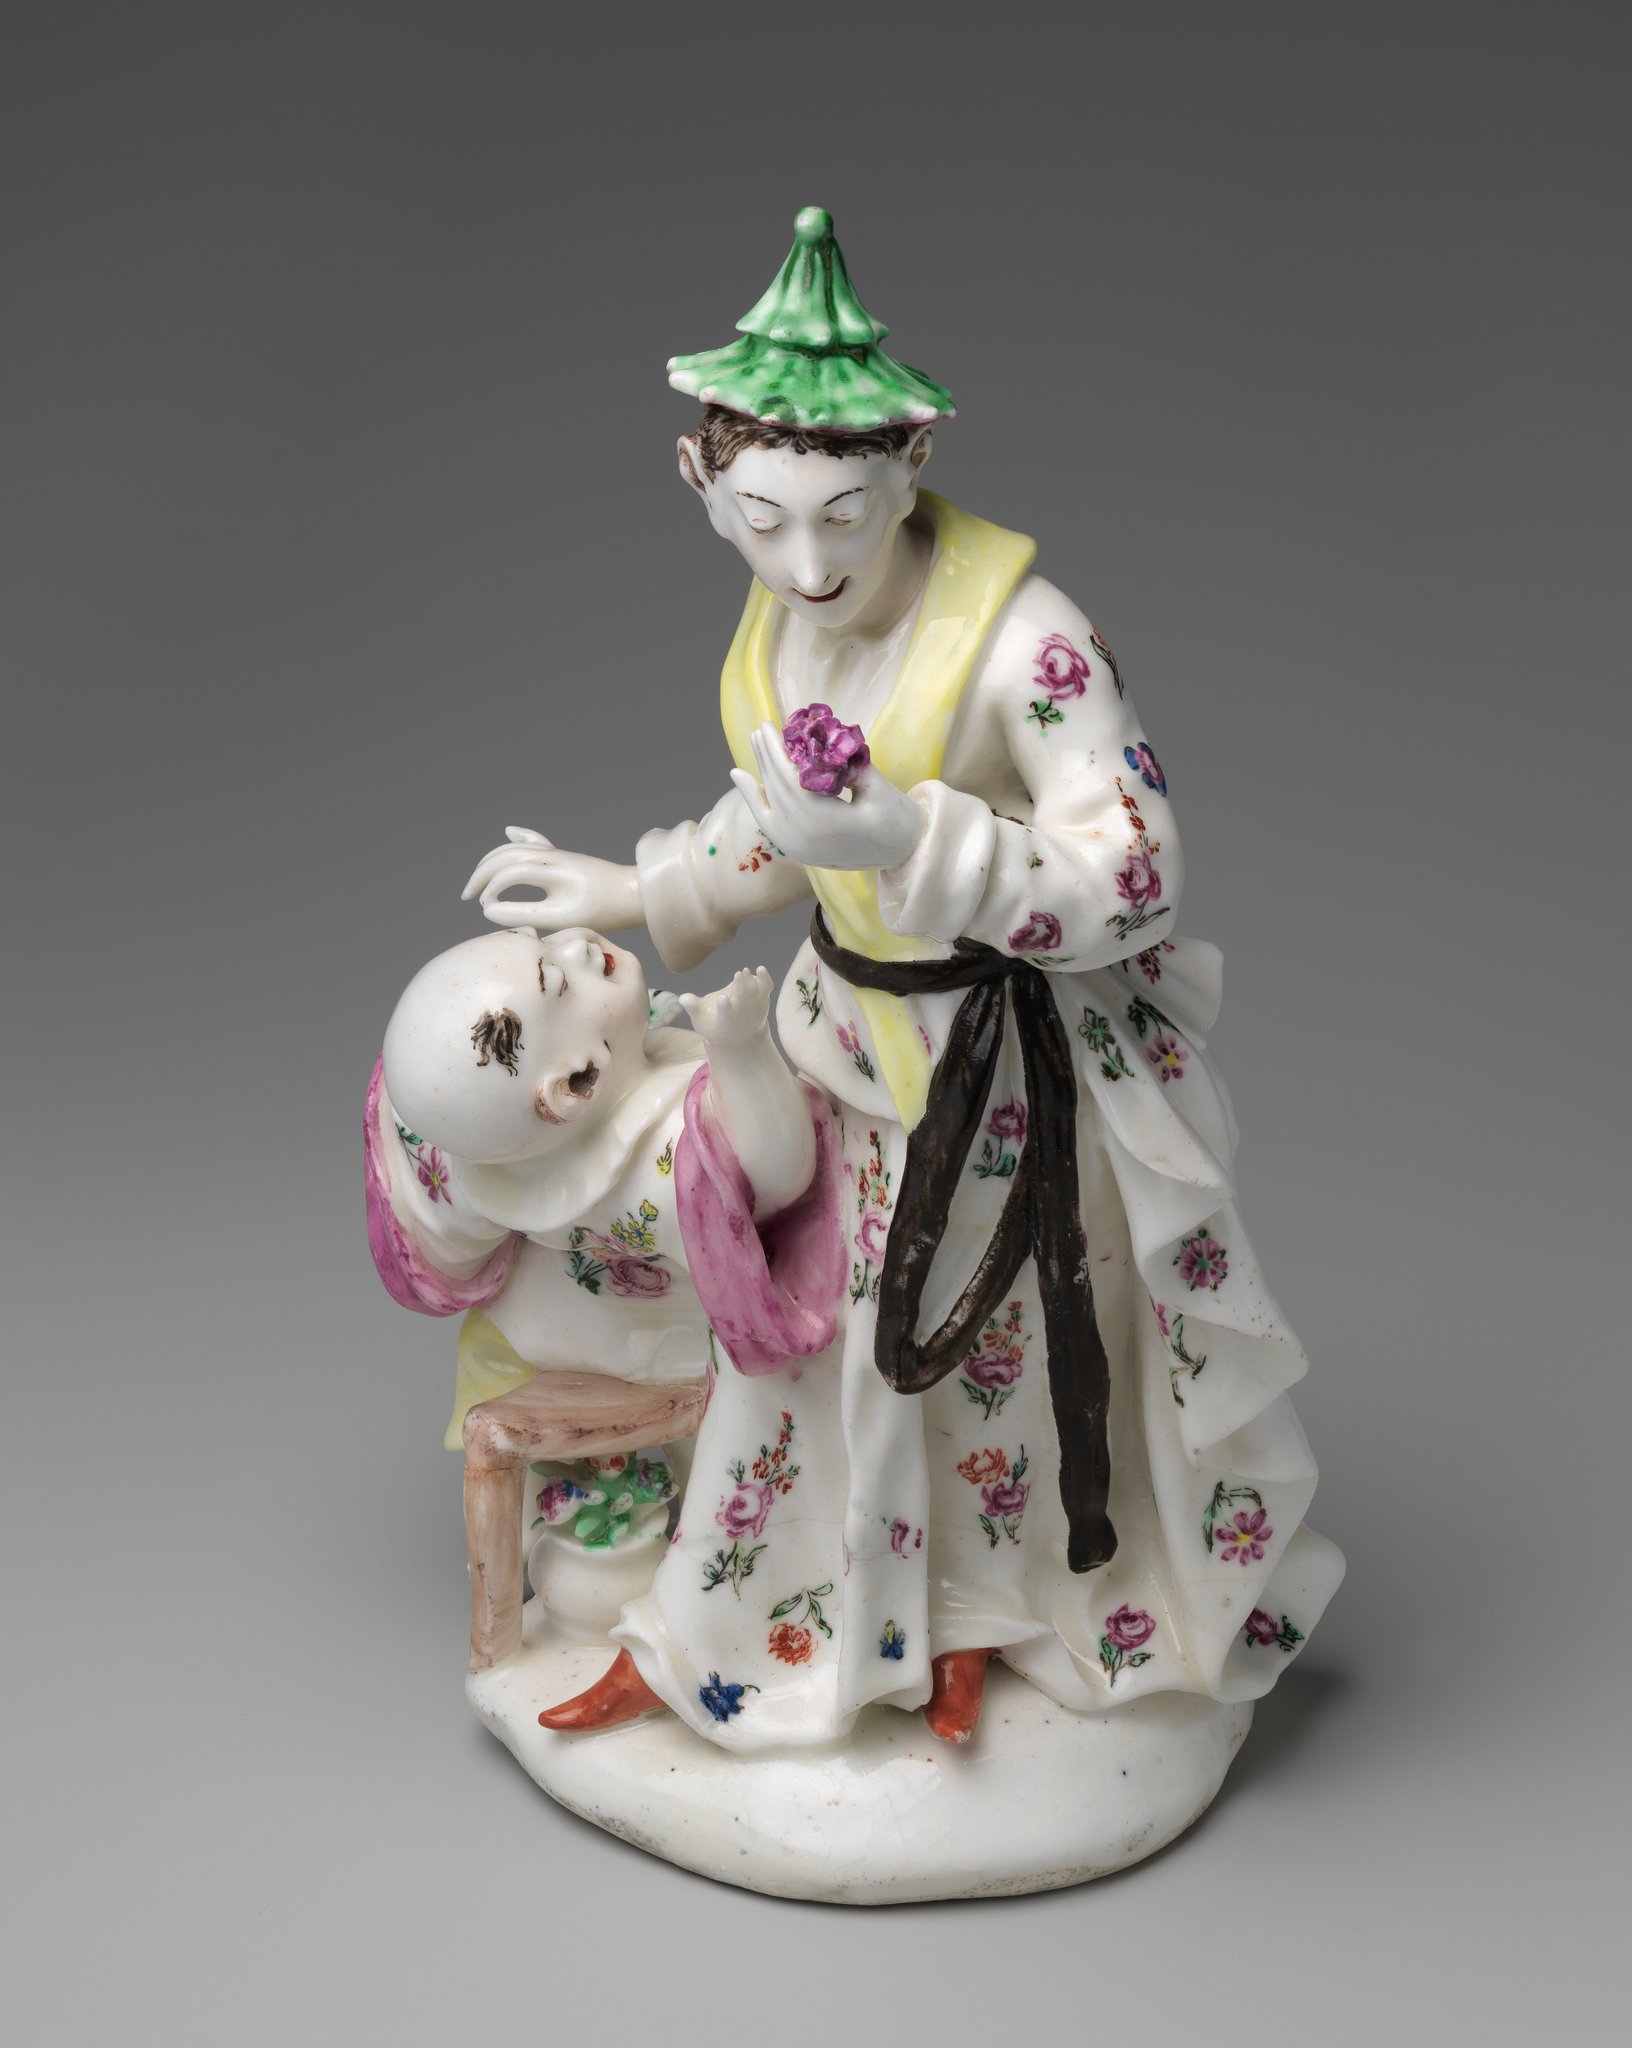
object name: group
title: Mother and child group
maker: derby porcelain manufactory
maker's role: factory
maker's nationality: british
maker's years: 1751-1785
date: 1750-1755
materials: soft paste porcelain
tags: chinoiserie,children,mothers